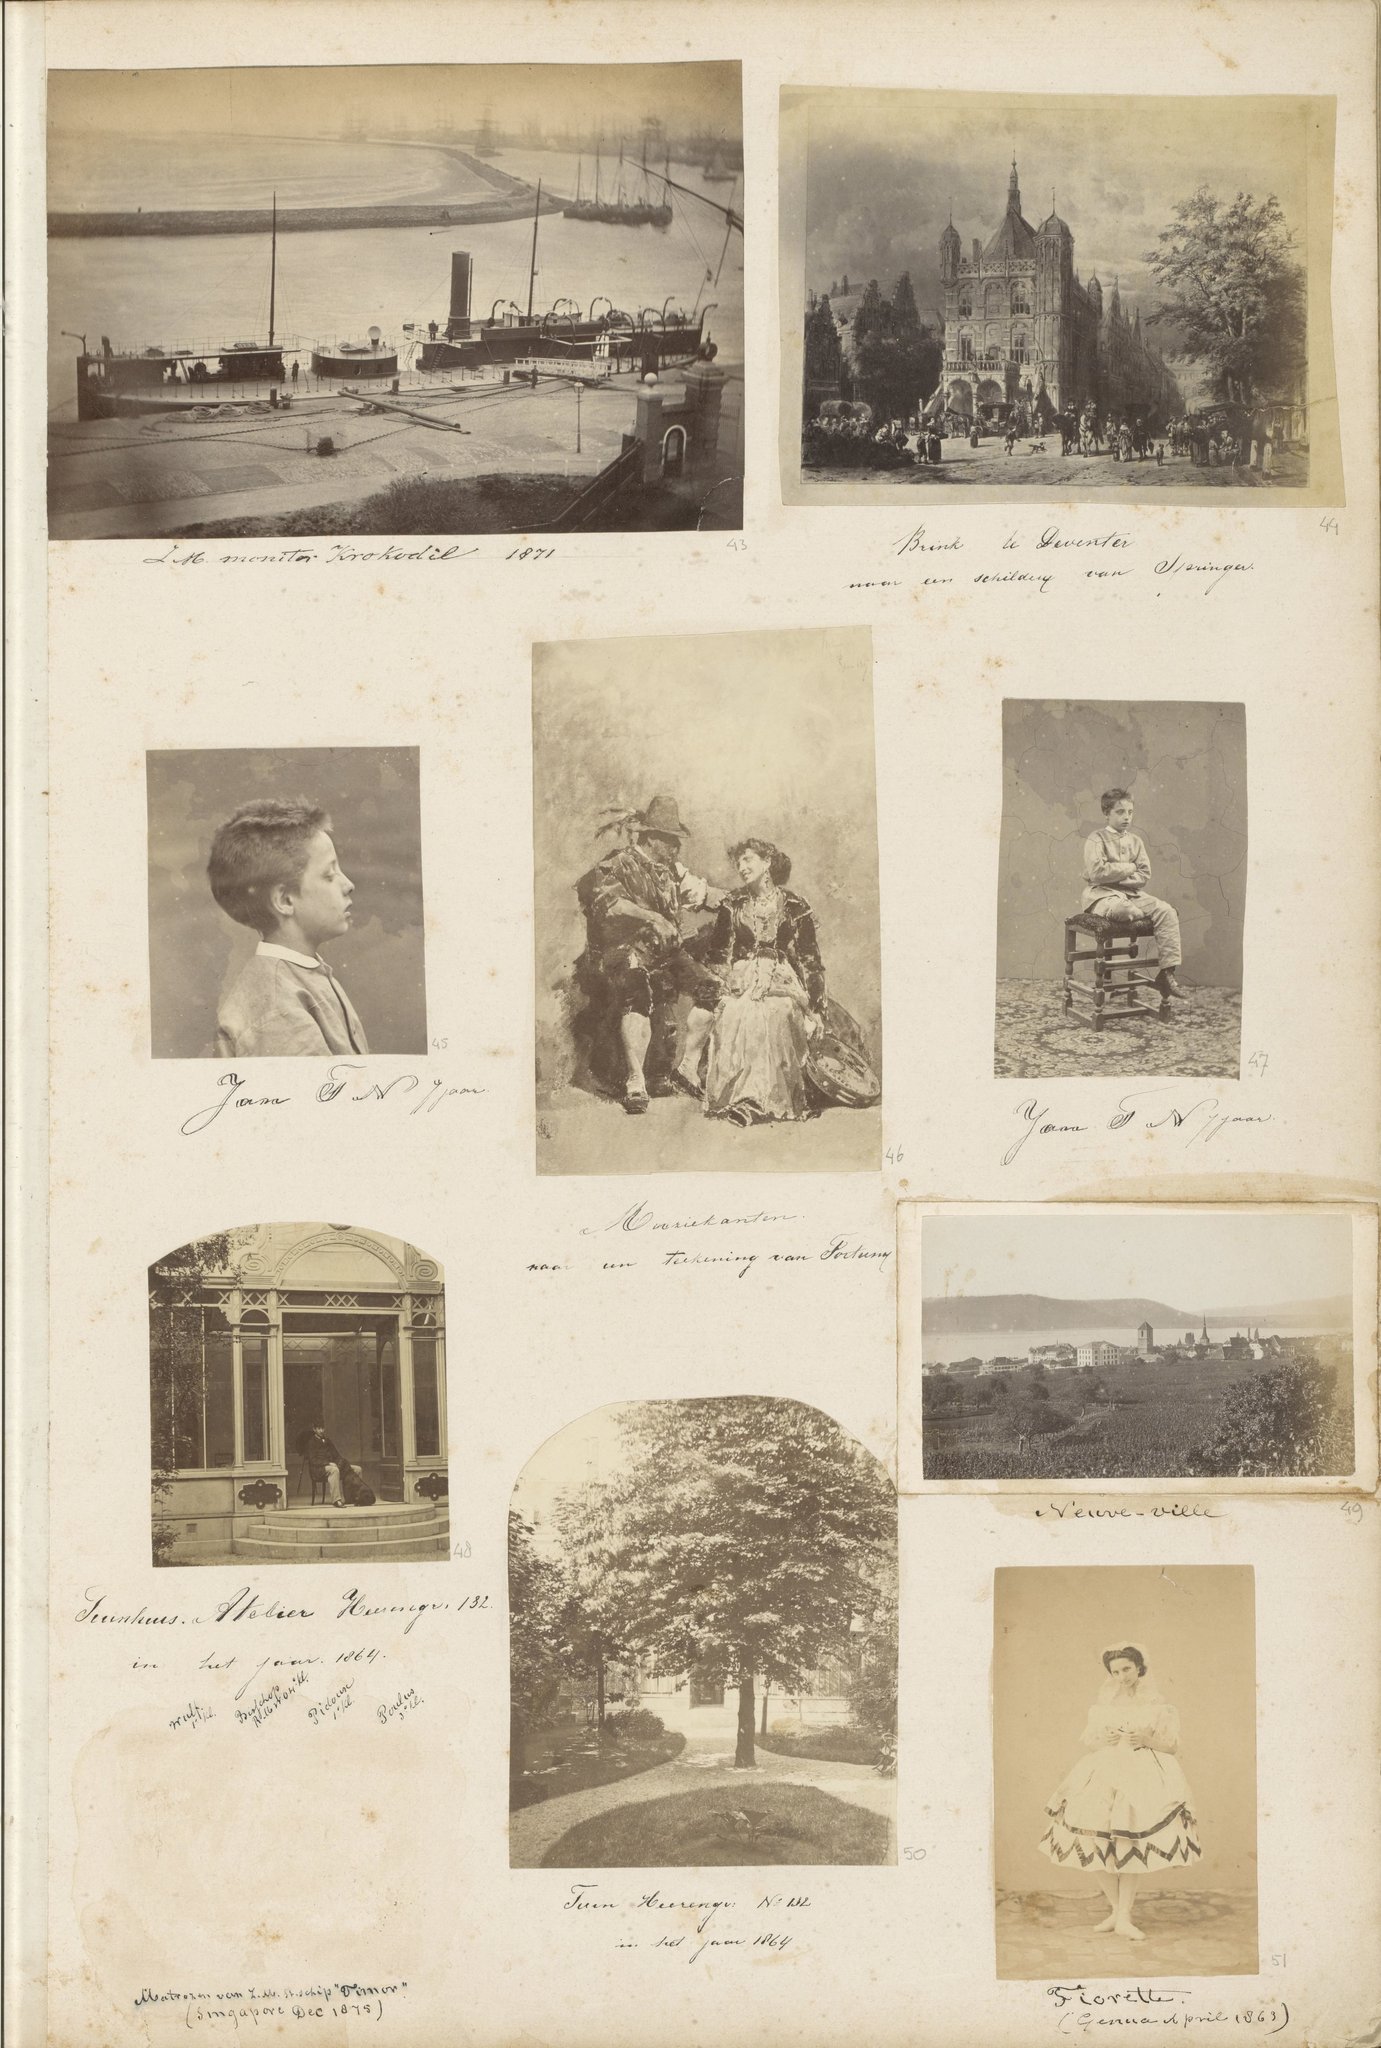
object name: photograph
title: Portret van een zevenjarige jongen, zittend op een kruk, aangeduid als Jan T.N.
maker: Anonymous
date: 1860-1870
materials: paper, photographic support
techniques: albumen print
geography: netherlands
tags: youth, adolescent, netherlands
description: Mogelijk betreft het Jan Tutein Nolthenius. Onderdeel van Fotoalbum van Robert Daniel Crommelin (1841-1907).